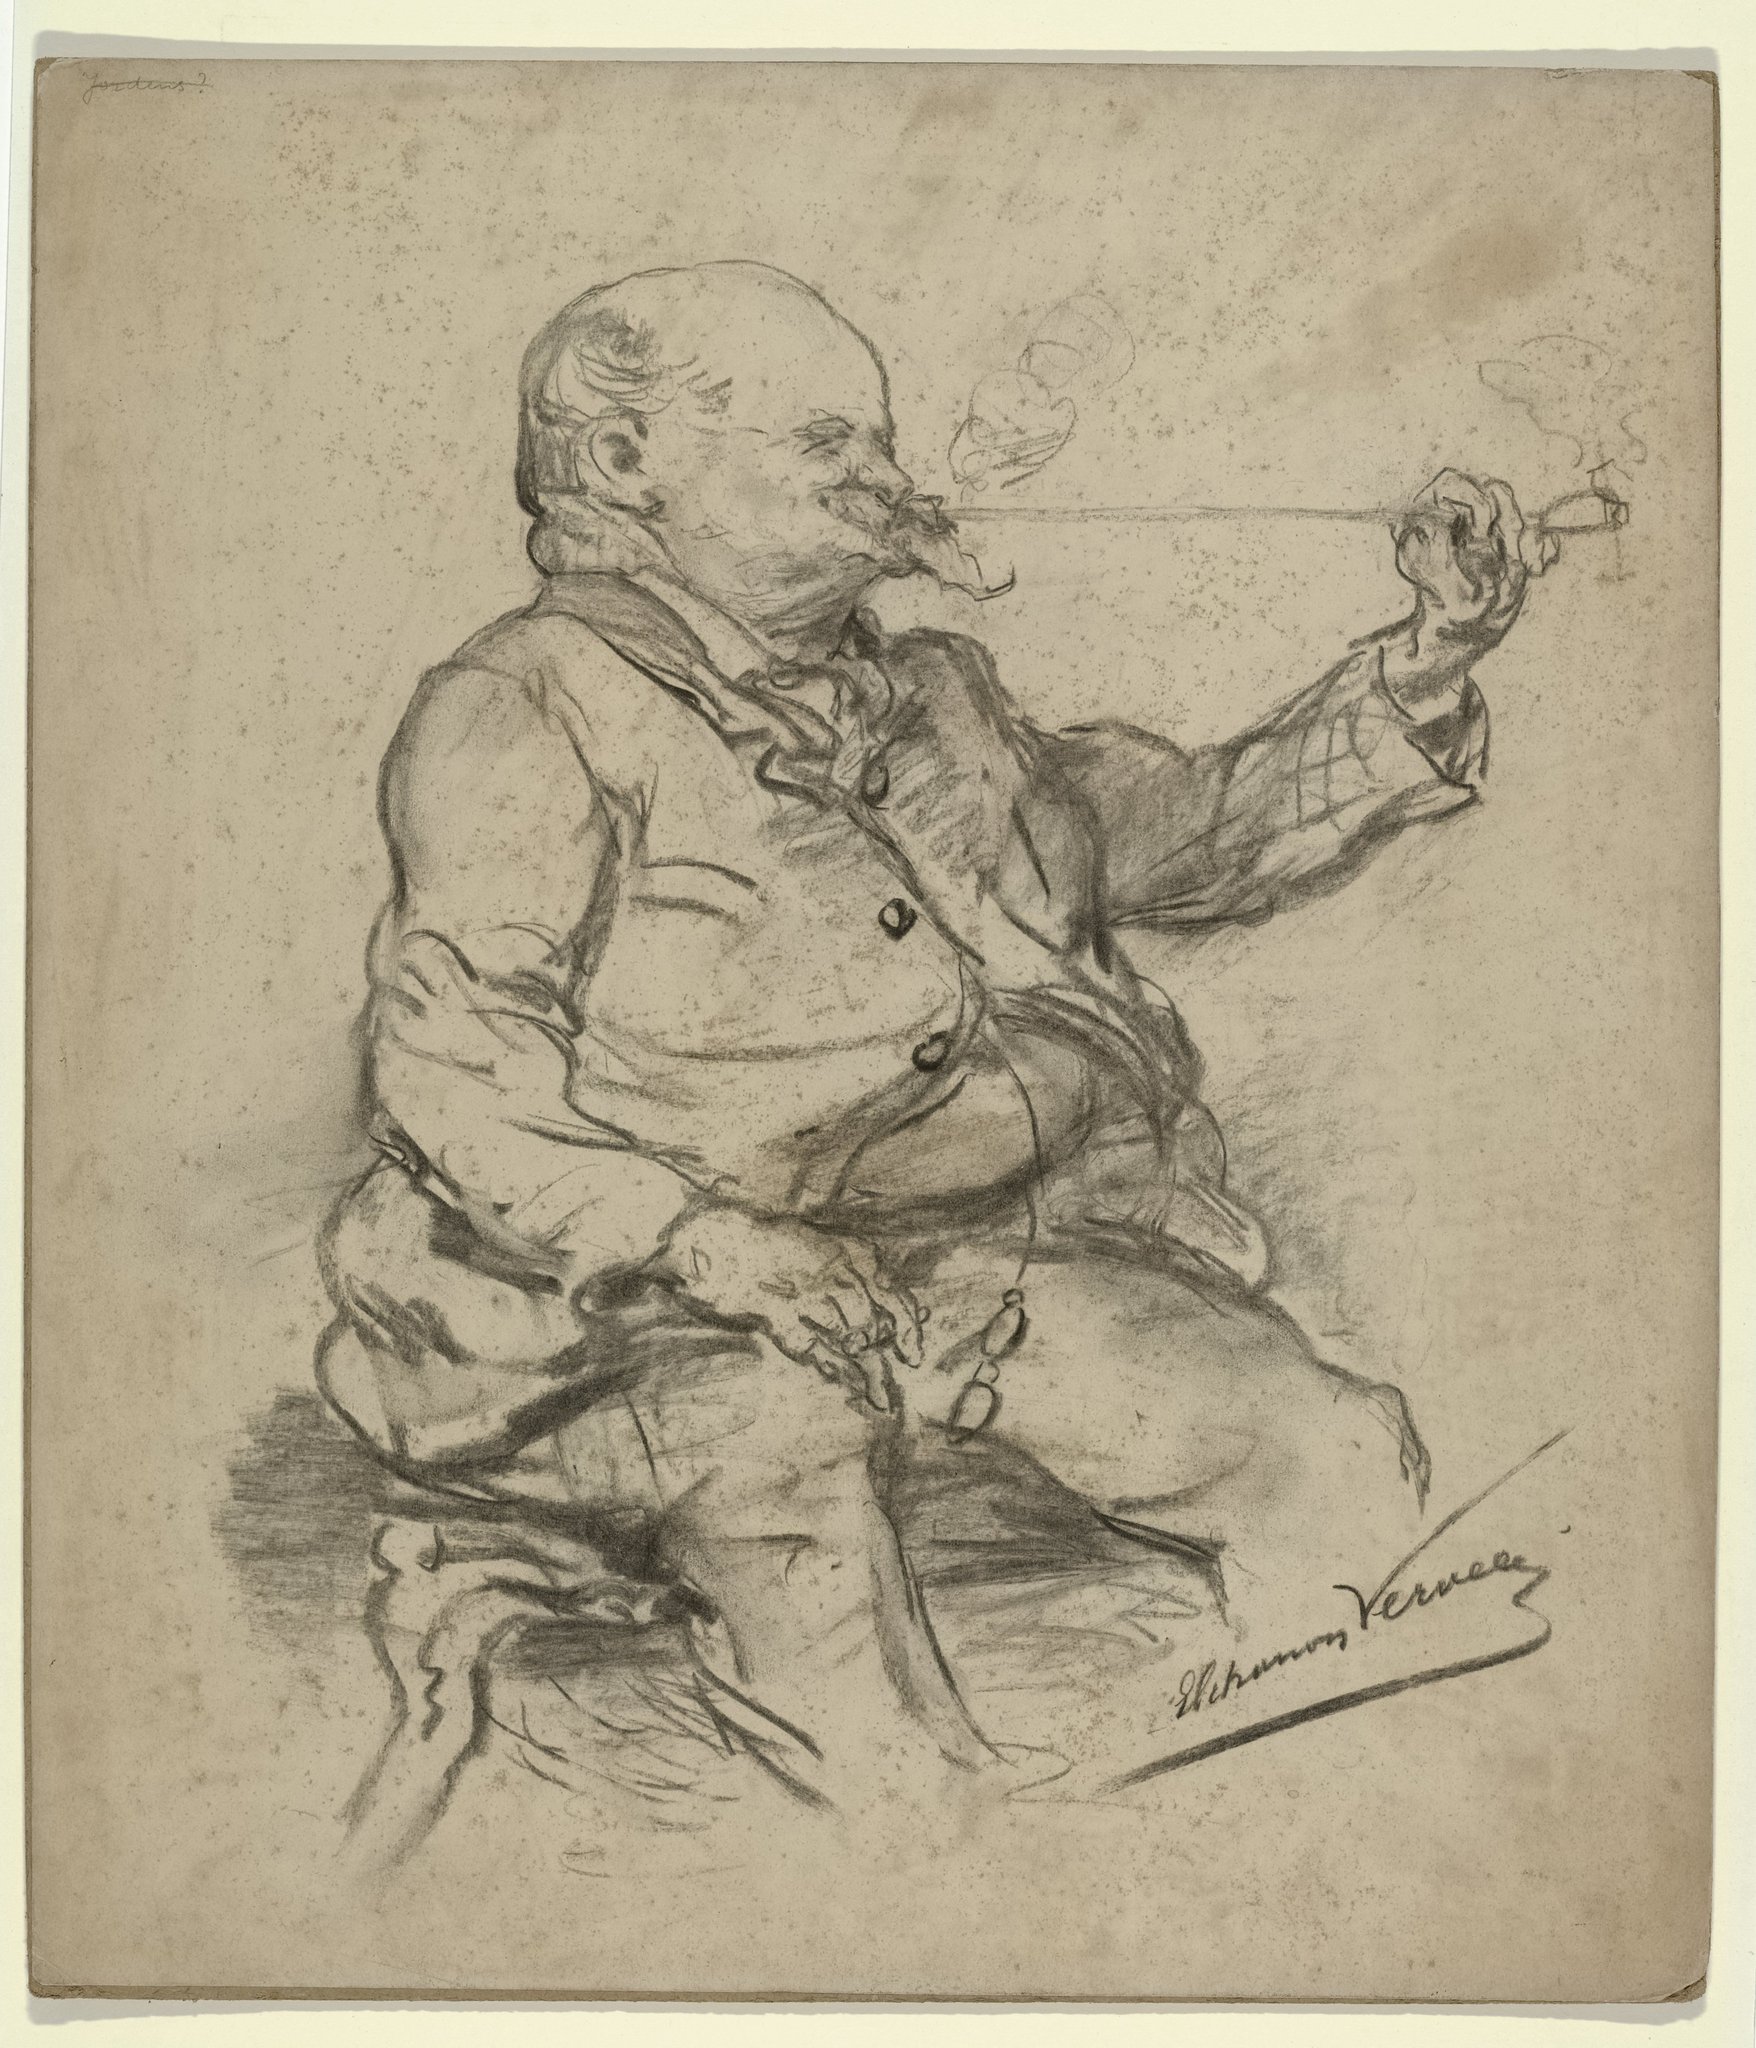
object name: drawing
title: Karikatuurportret van de kunstschilder Martinus Wilhelmus Liernur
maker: elchanon verveer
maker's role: draughtsman, print maker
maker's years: 1826-1900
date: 1850-1899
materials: charcoal, paper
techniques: stumping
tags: the hague, martinus wilhelmus liernur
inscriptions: signature: ‘Elchanon Verveer’, inscription: ‘Liernur / Jordens? (doorgestreept)’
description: Karikatuurportret van de kunstschilder Martinus Wilhelmus Liernur (1833-1901).